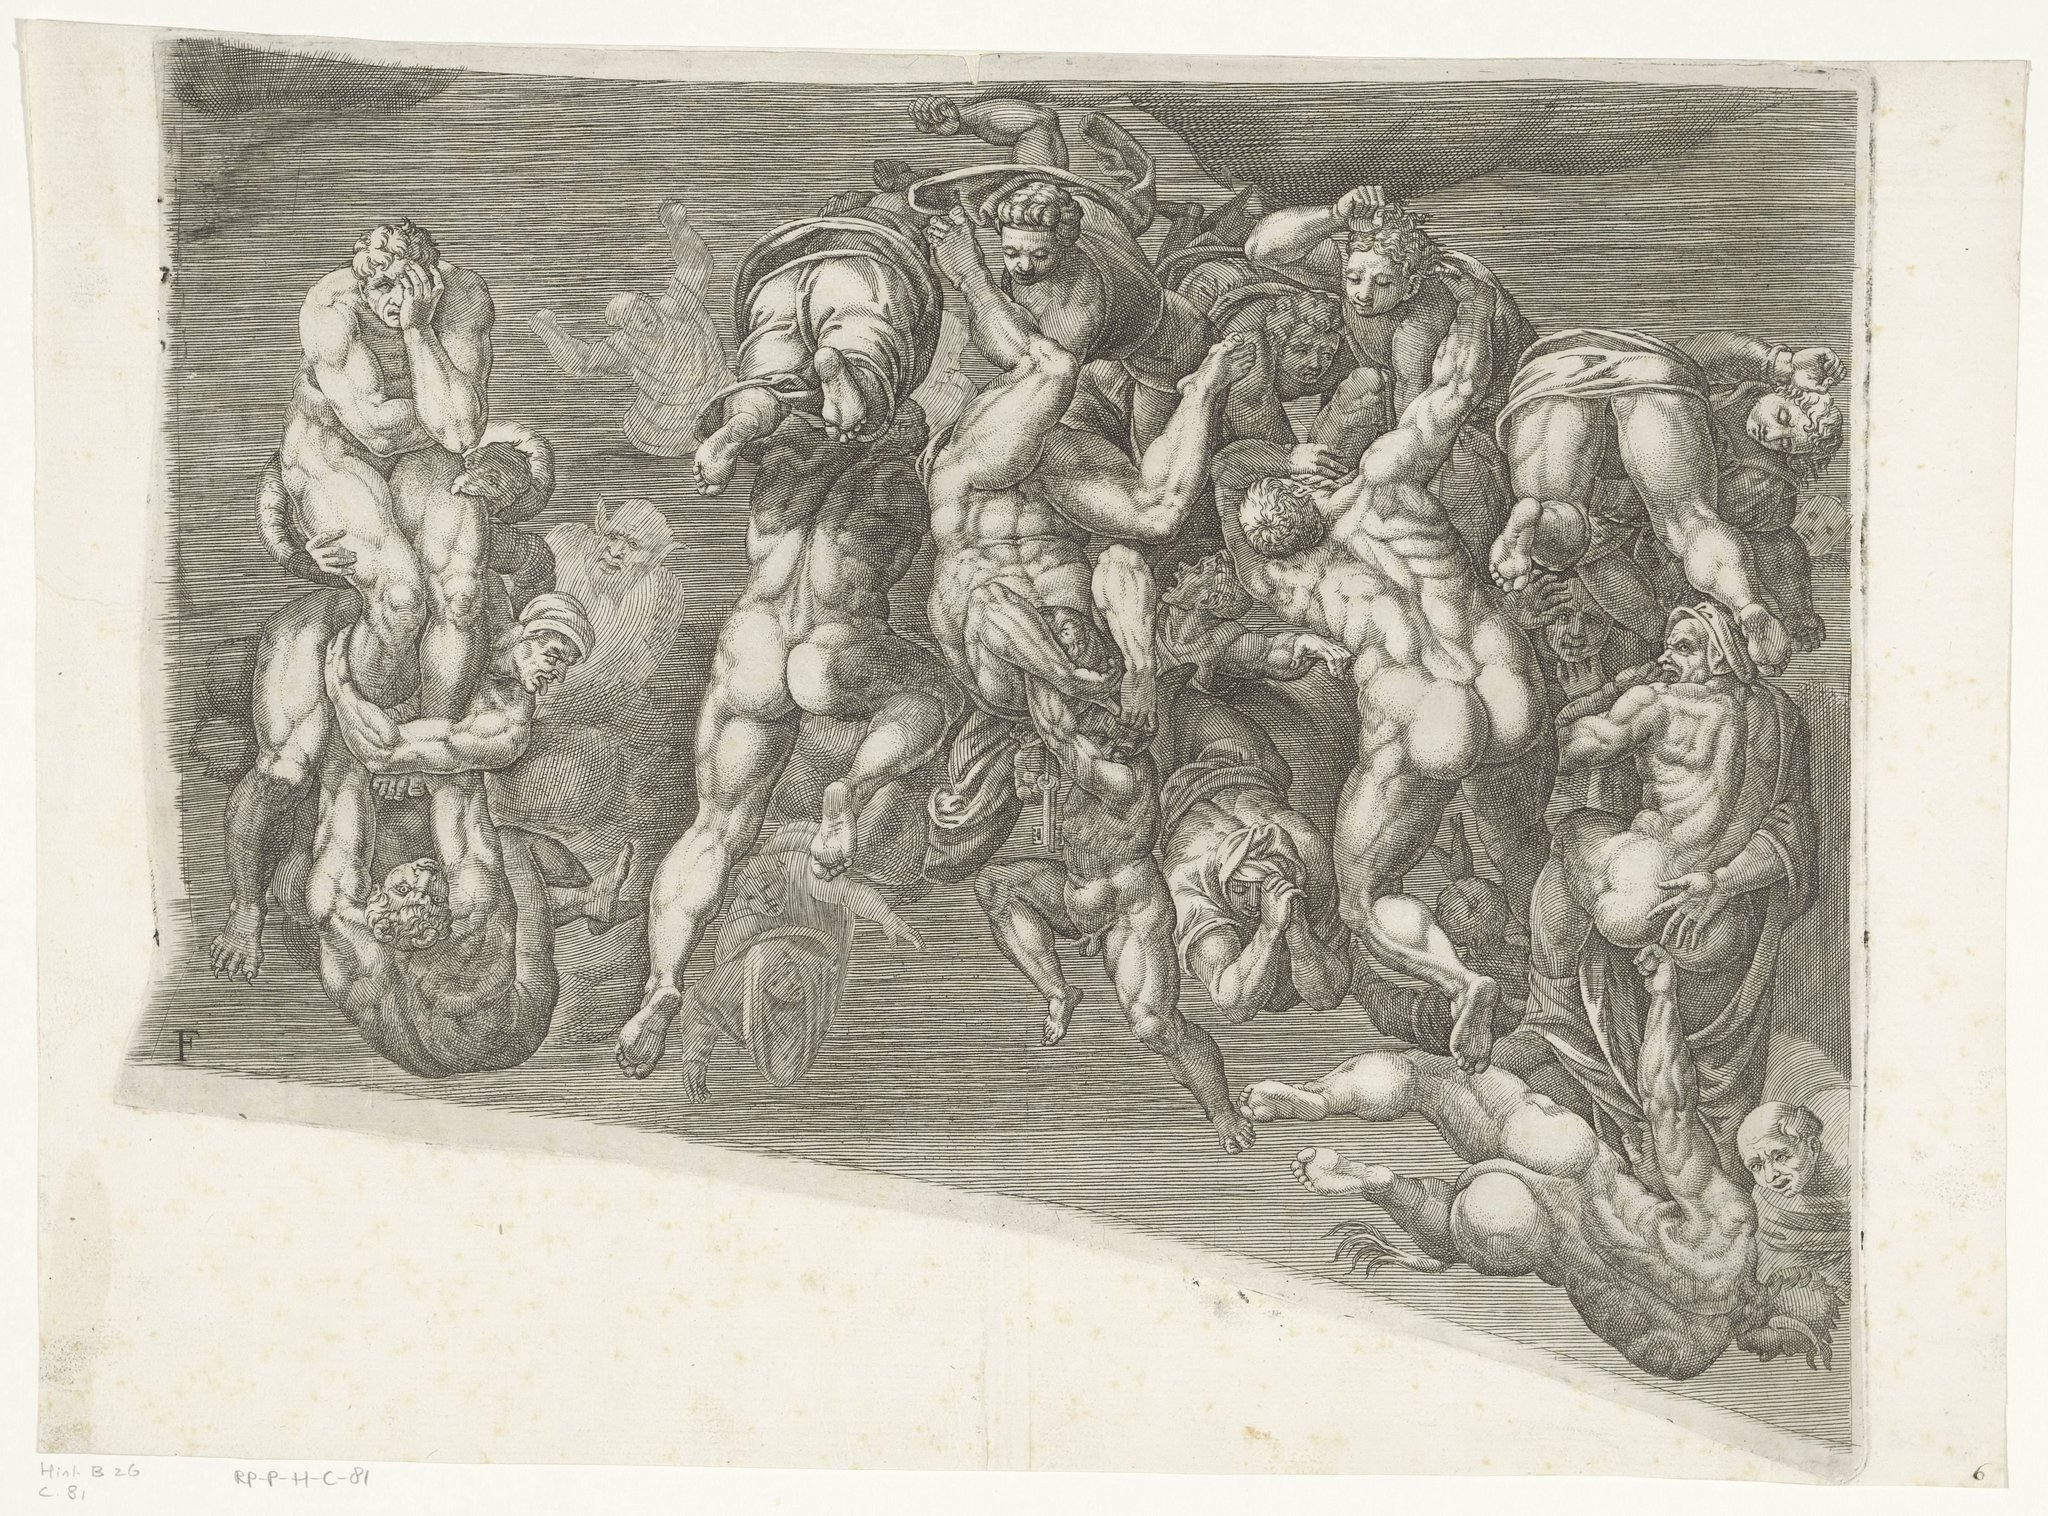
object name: print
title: Het laatste oordeel, blad F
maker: giorgio ghisi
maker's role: print maker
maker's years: 1520-1582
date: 1530-1582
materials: paper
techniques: engraving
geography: vatican city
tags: last judgement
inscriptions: collector's mark: Lugt 11, number: ‘6’, collector's mark: ‘Hinloopen’, collector's mark: Lugt 10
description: Prent maakt deel uit van een groep van tien prenten die samen één grote voorstelling vormen naar het fresco met het Laatste Oordeel door Michelangelo in de Sixtijnse Kapel in het Vaticaan.